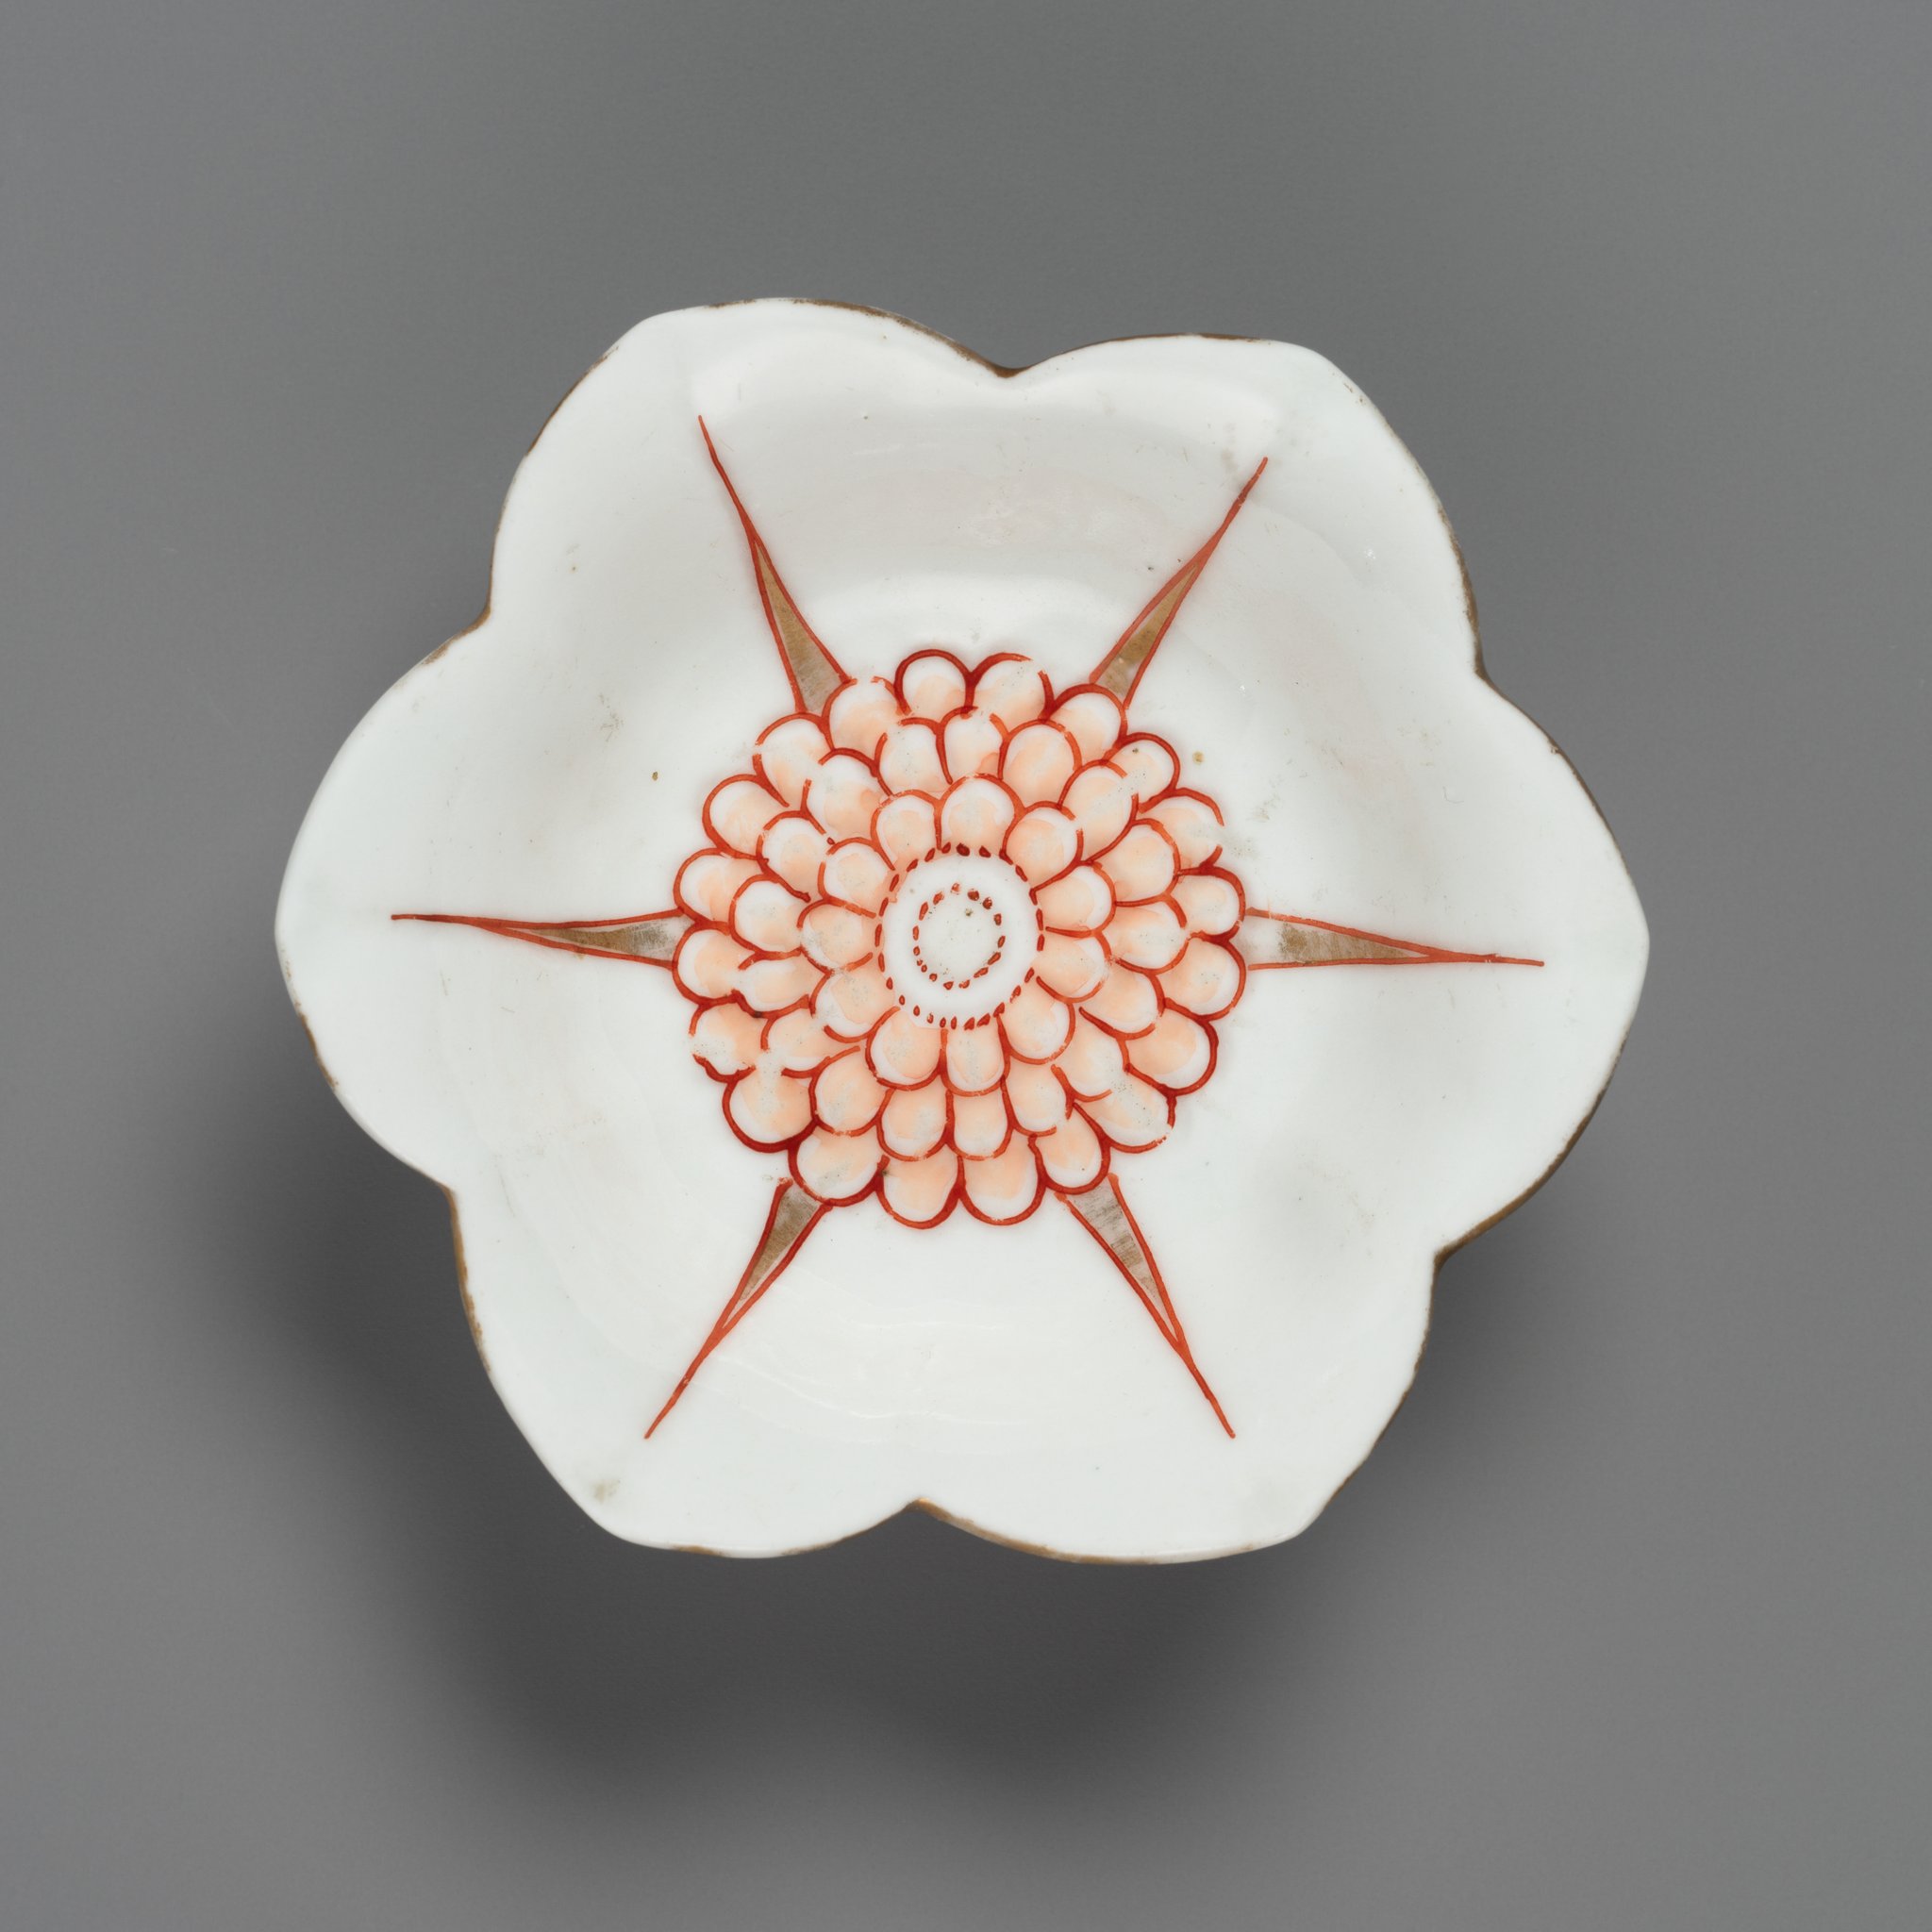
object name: cup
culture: japanese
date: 1801-1900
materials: porcelain